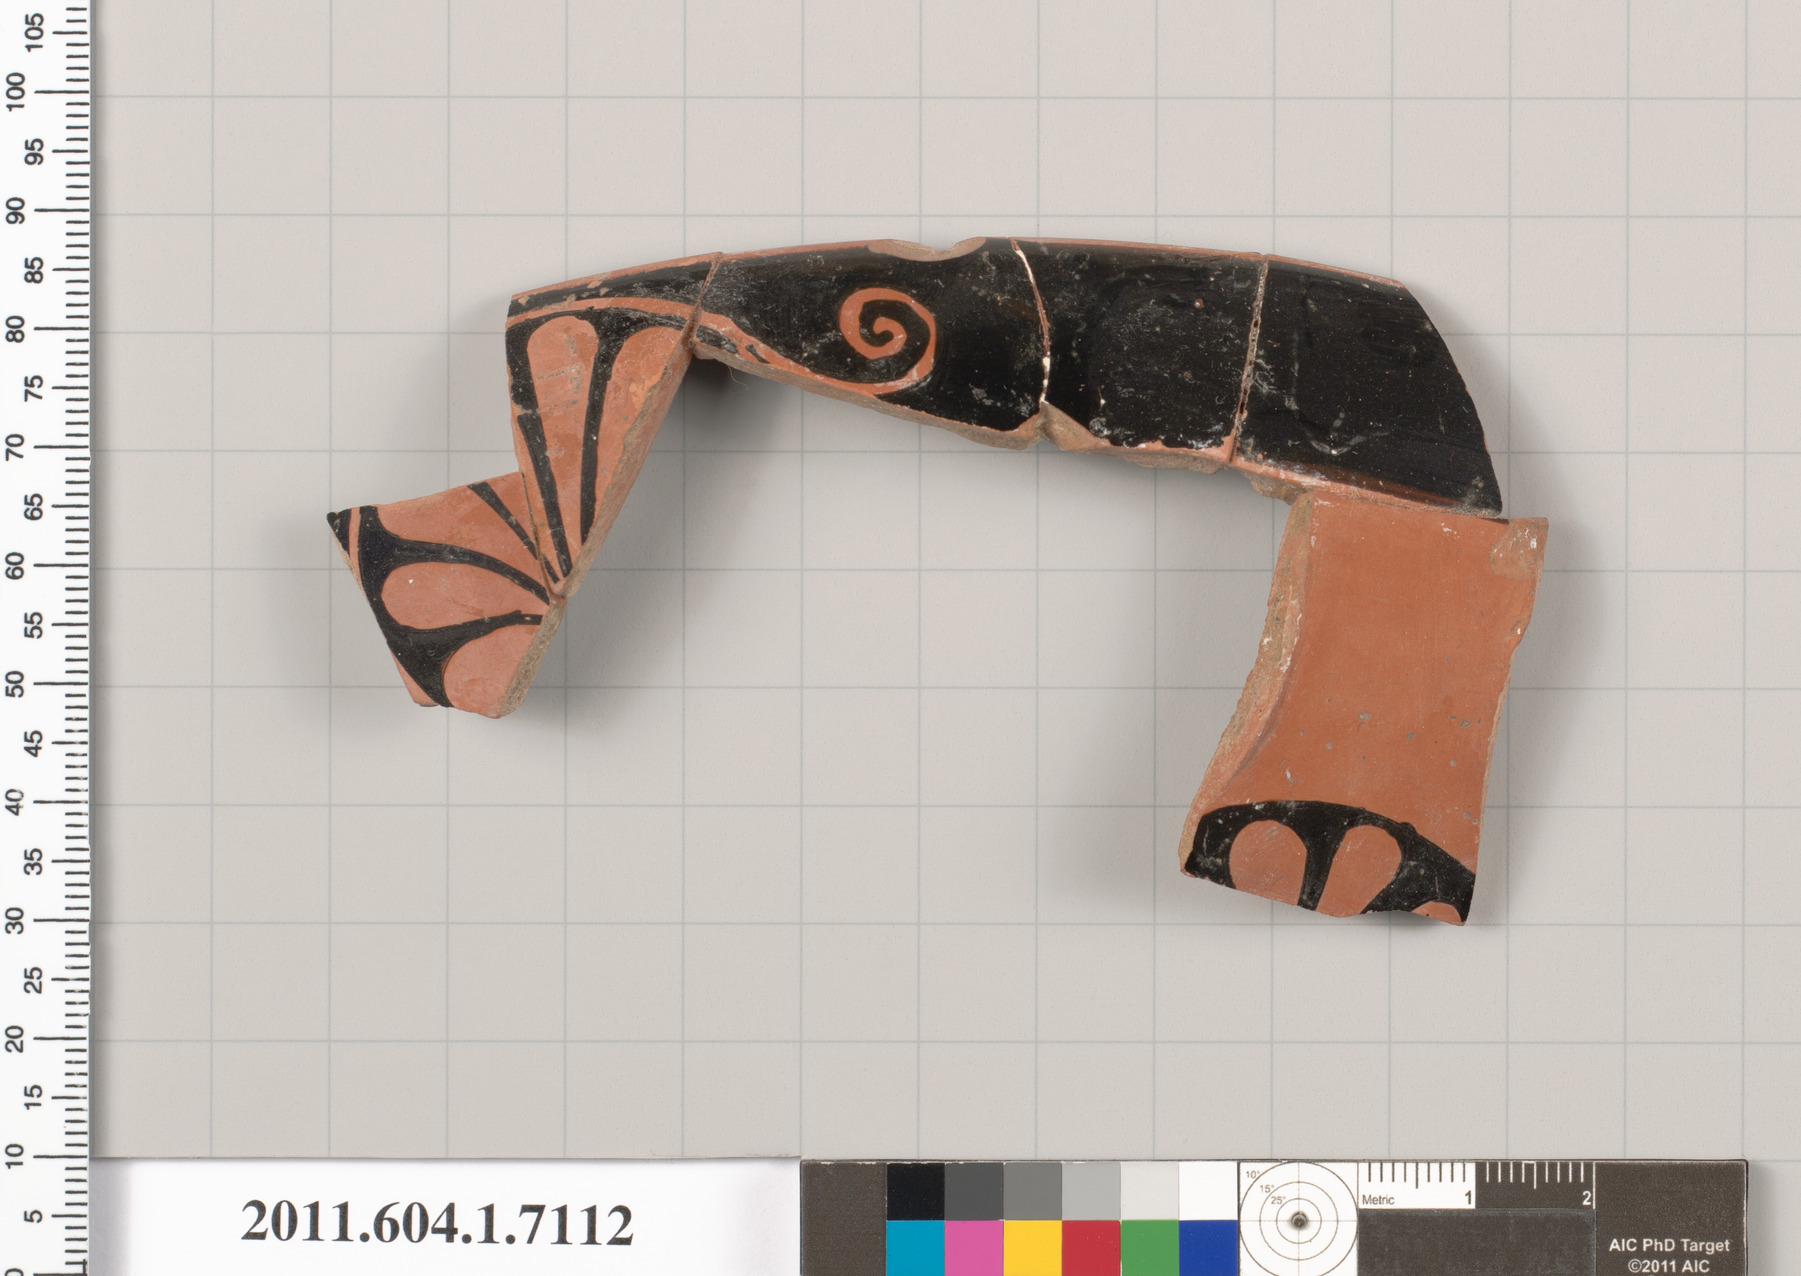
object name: kylix fragment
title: Terracotta rim fragment of a kylix (drinking cup)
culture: greek, attic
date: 500-480 BCE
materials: terracotta